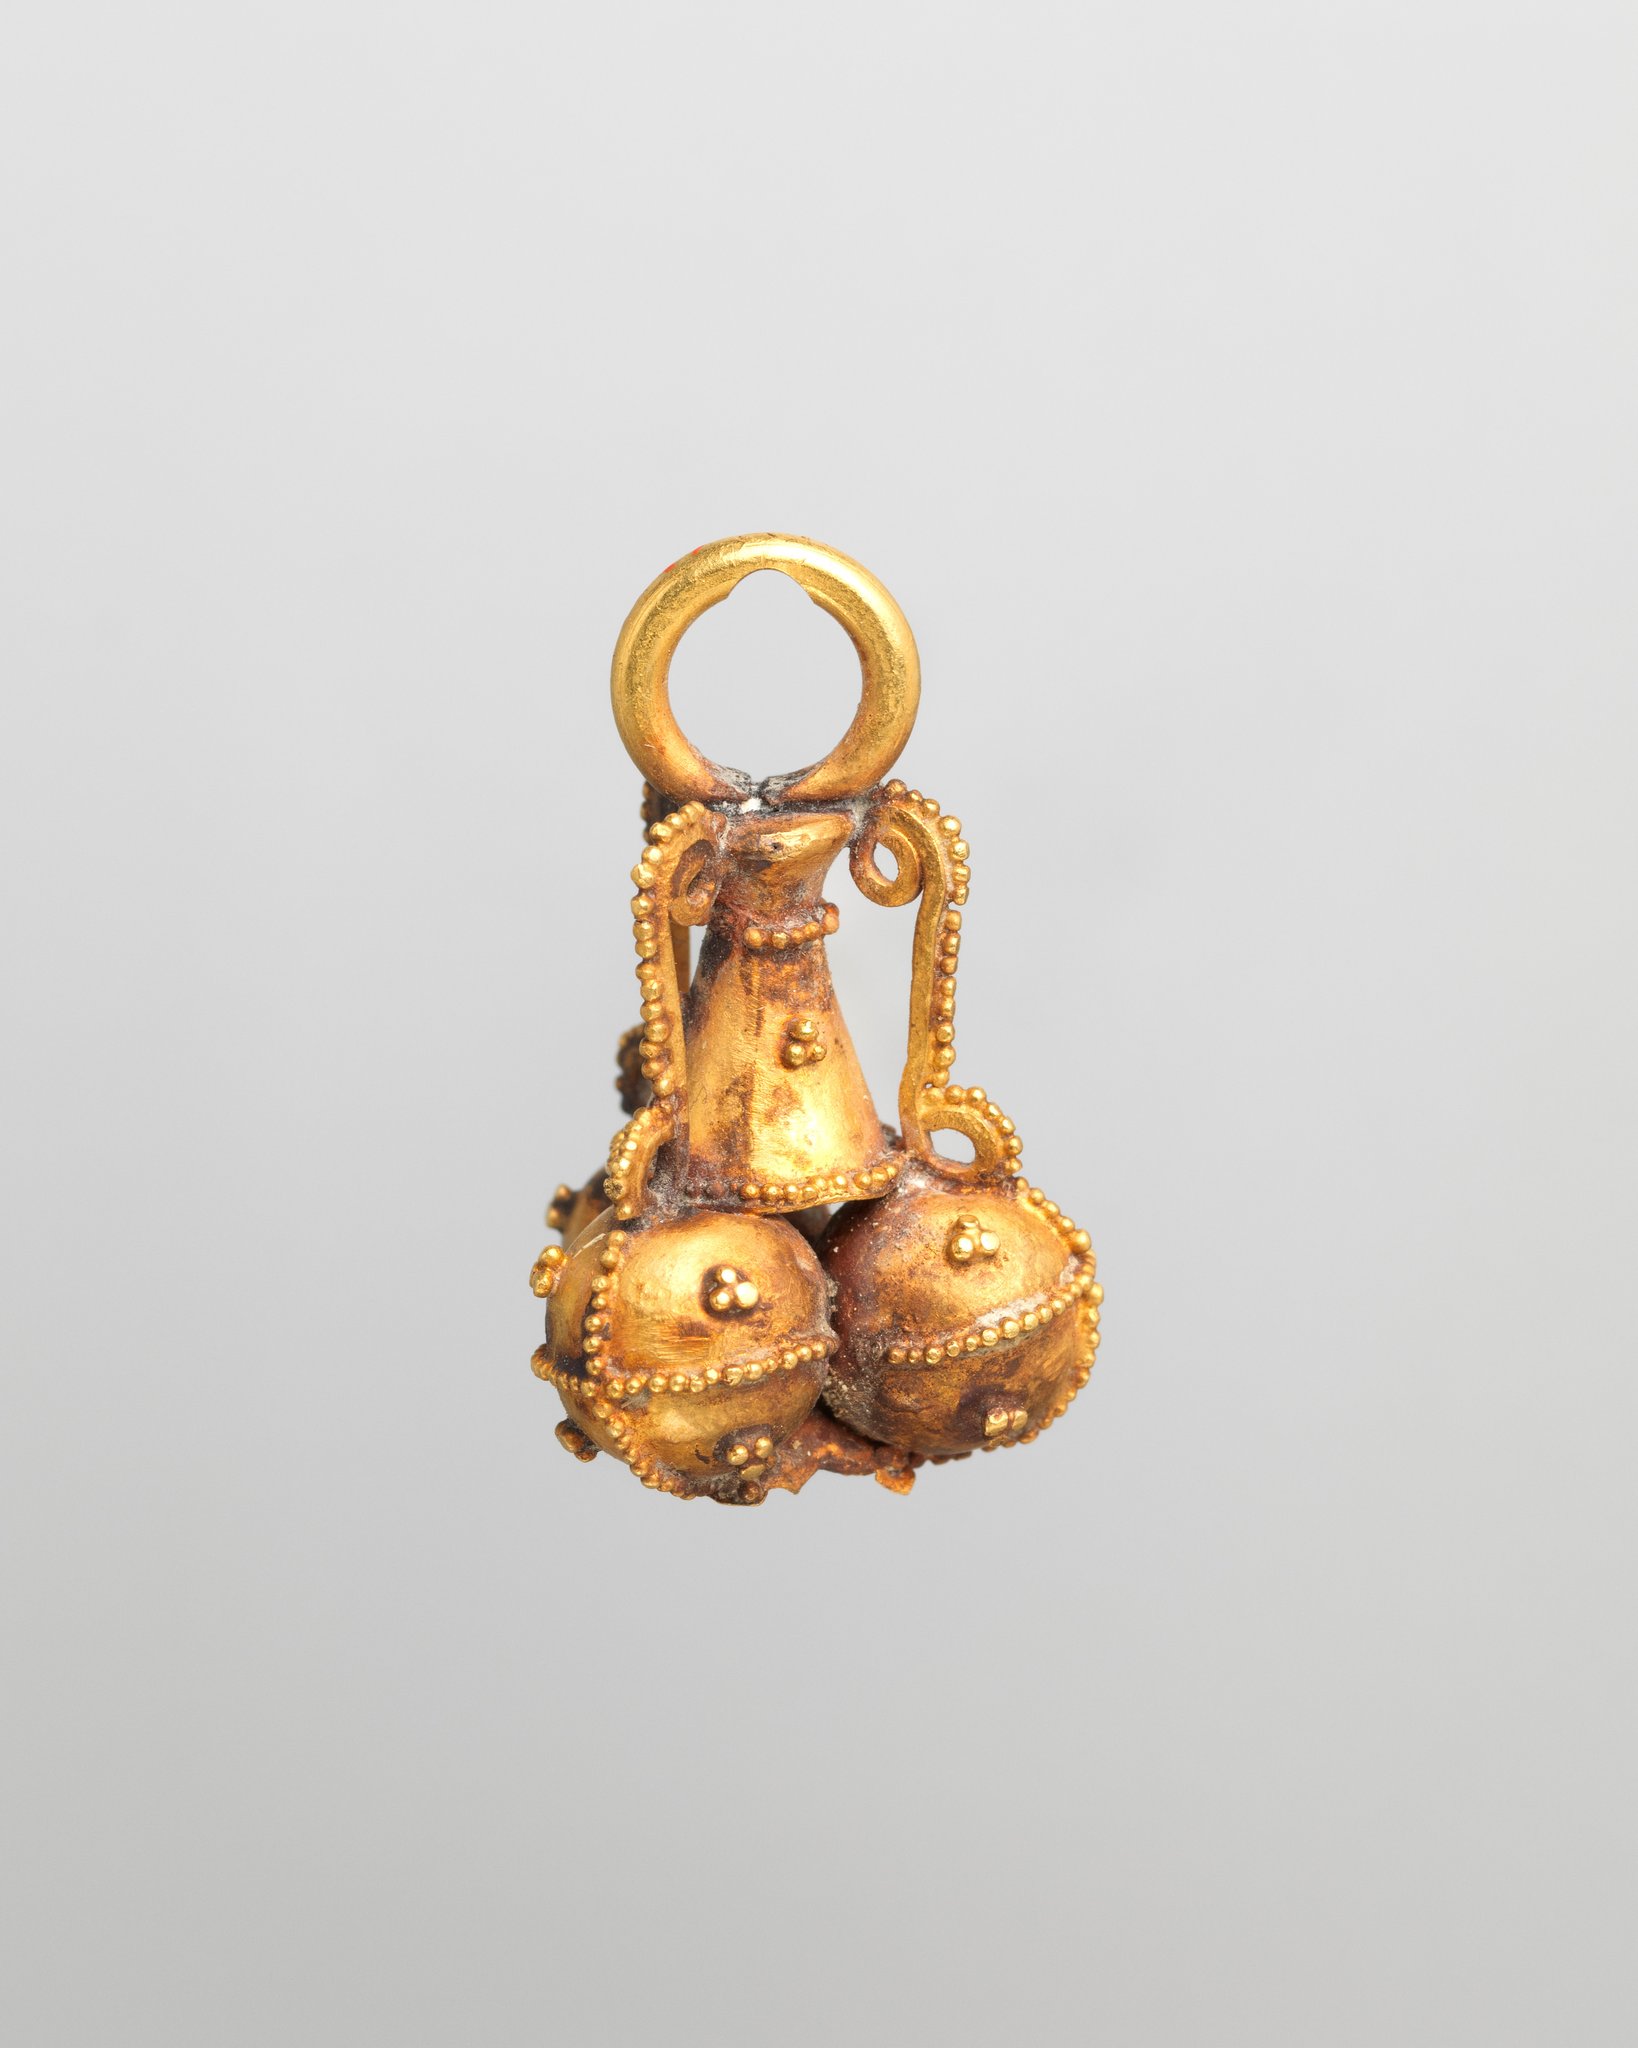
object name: earring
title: Earrings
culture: parthian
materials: gold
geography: mesopotamia